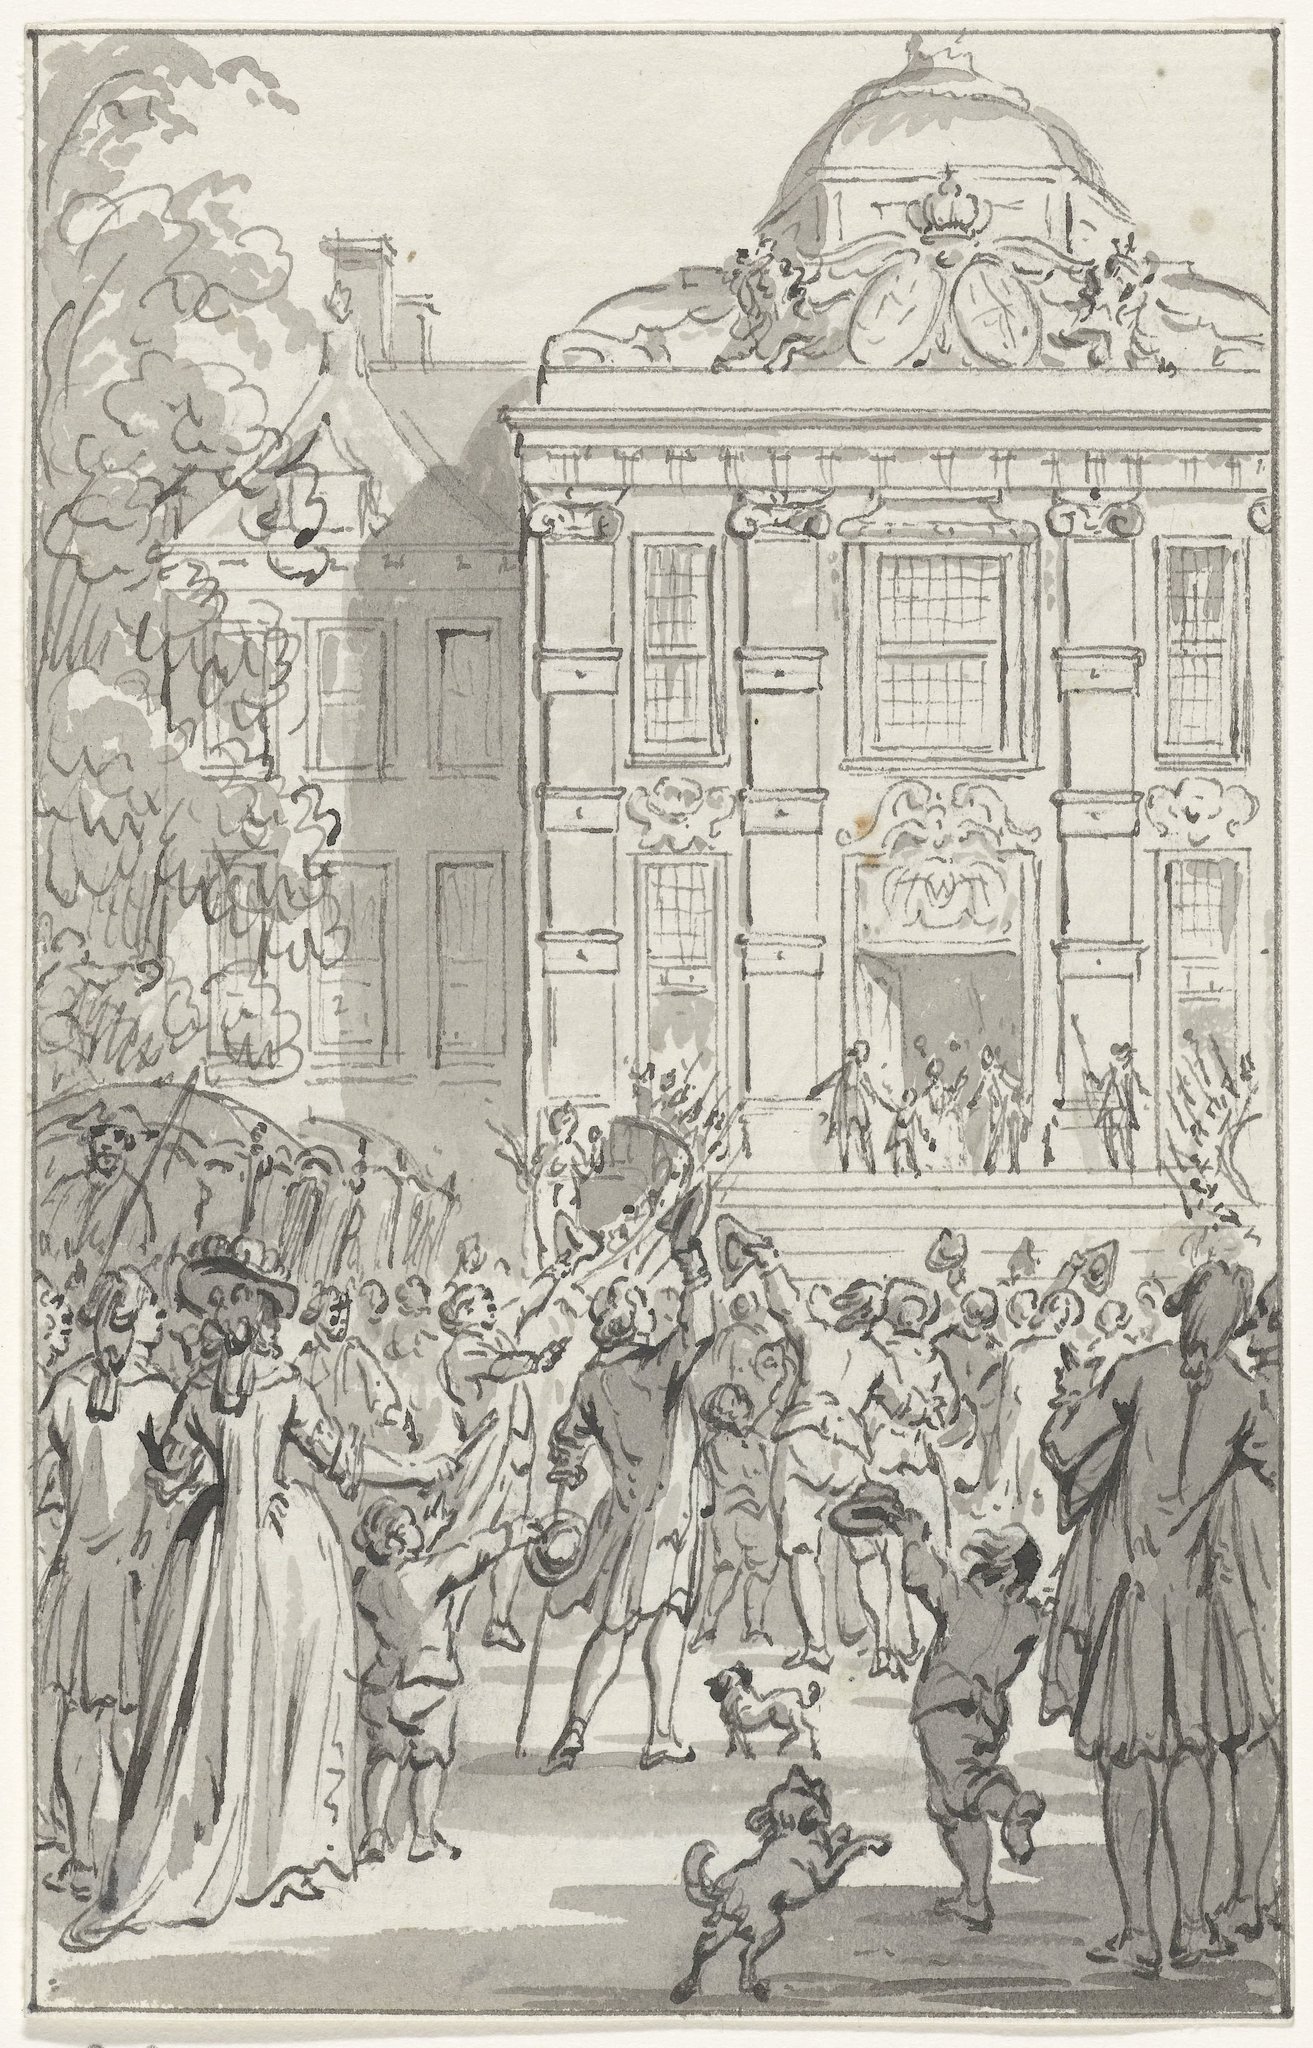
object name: drawing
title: Willem V vertoont zich als Ridder in de Orde van de Kousenband op het bordes van Huis ten Bosch, 1752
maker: jacobus buys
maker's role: draughtsman, print maker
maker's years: 1724-1801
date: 1786-1788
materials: paper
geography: northern netherlands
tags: the hague, william v (prince of orange), knighthood order (garter)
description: Niet in Frederik Muller; door het RPK toegevoegd nummer. Ontwerptekening voor illustratie in: P.A. Loosjes, Vaderlandsche historie, vervattende de geschiedenissen der Vereenigde Nederlanden [...].Twee-en-twintigste deel. Beginnende met den jaare 1752 en eindigende met den jaare 1758 ... ten onmiddelyken vervolge van Wagenaar's Vaderlandsche historie.